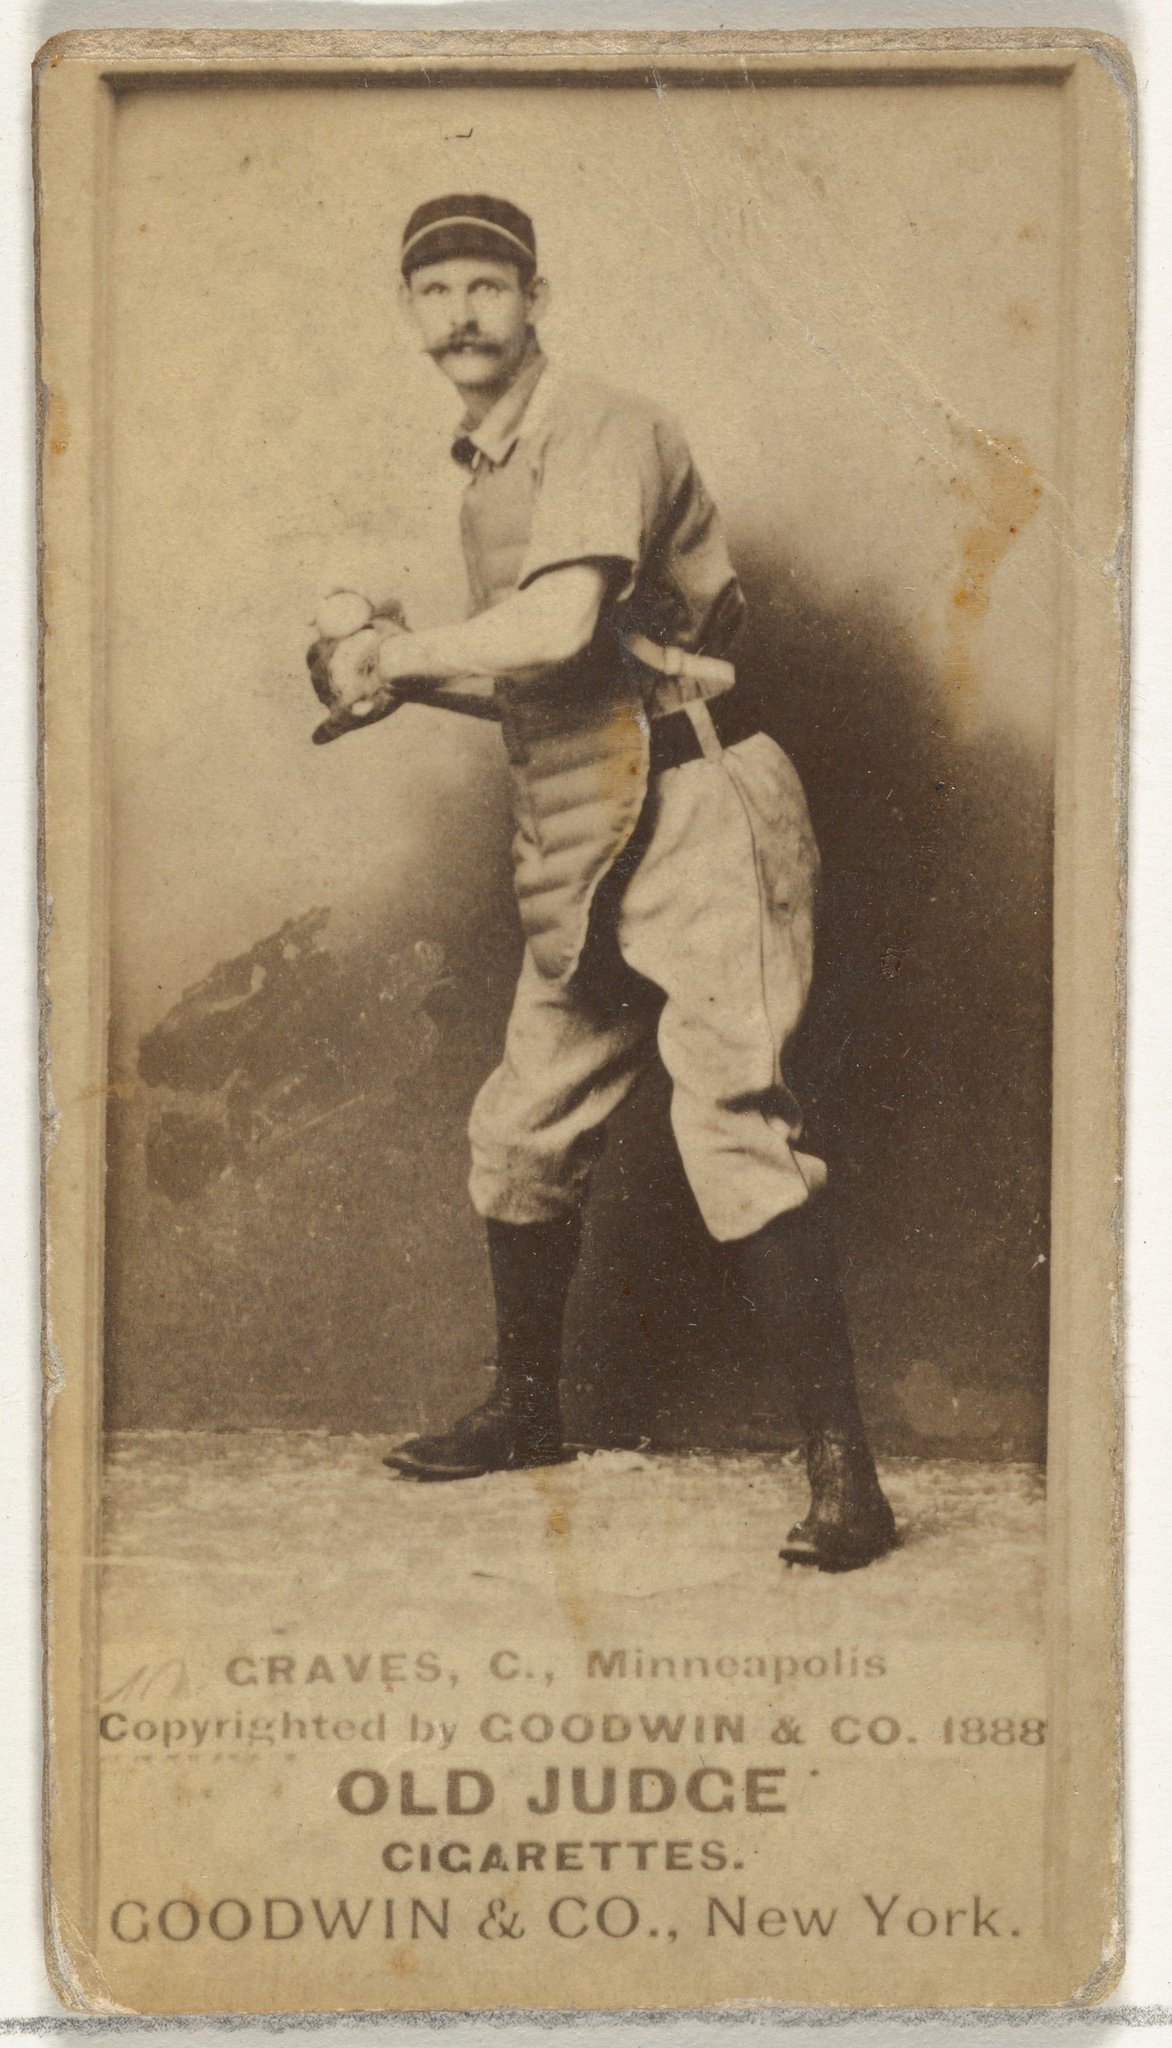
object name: baseball card, photograph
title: Frank Norris Graves, Catcher, Minneapolis, from the Old Judge series (N172) for Old Judge Cigarettes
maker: goodwin & company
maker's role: publisher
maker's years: 1850-1950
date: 1888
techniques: albumen silver print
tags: men,portraits,baseball,athletes